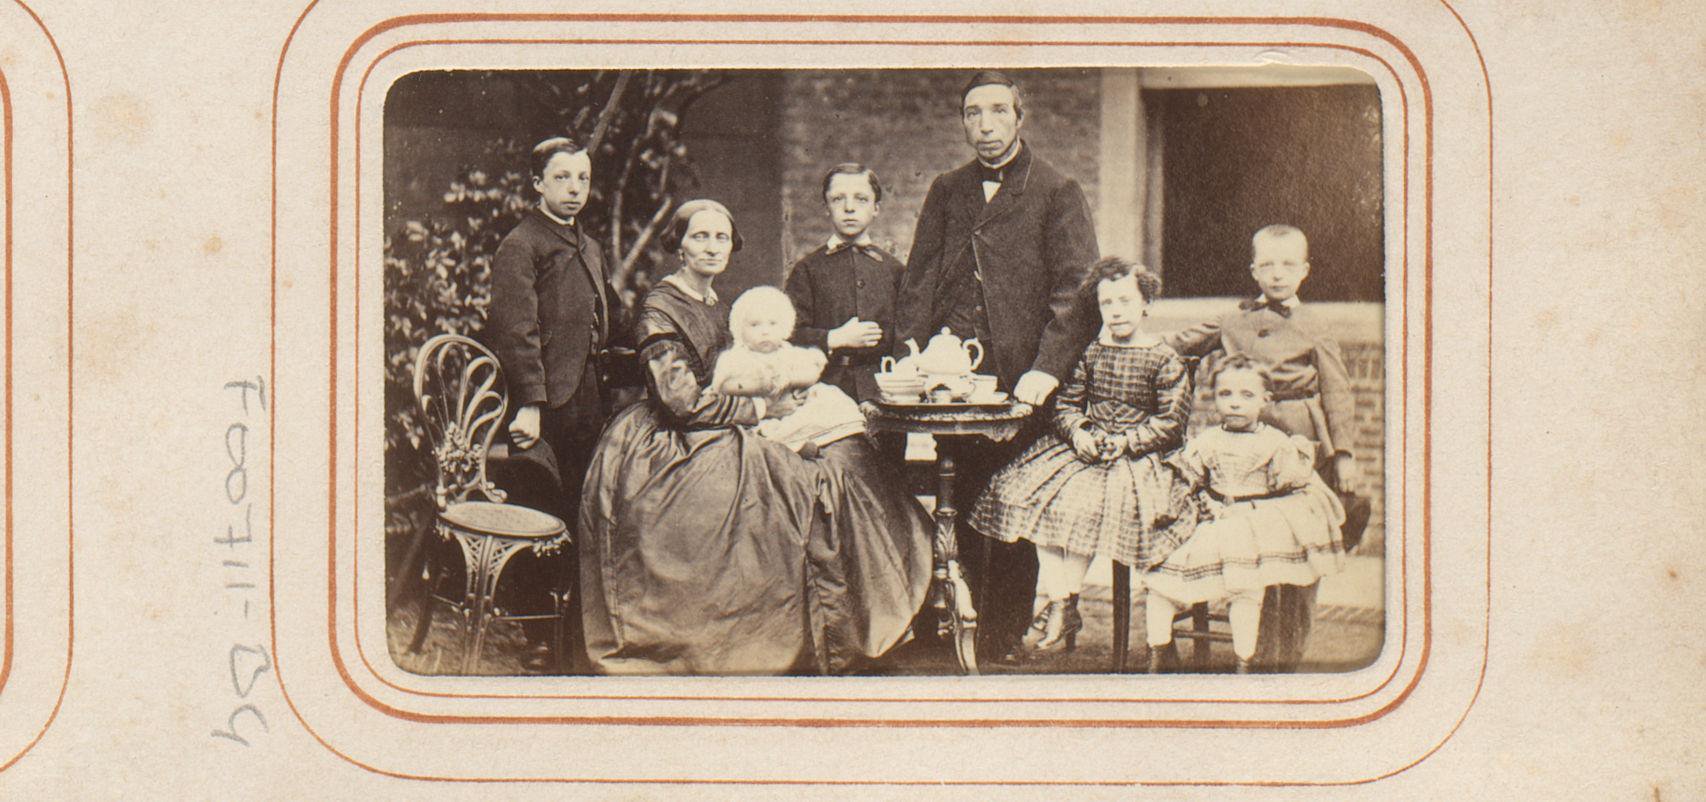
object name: carte de visite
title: Familieportret, buiten met theeservies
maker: leendert de koningh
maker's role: draughtsman, print maker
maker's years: 1777-1849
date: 1865-1887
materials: cardboard, photographic support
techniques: albumen print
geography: dordrecht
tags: tea- and coffee-service, anonymous historical persons portrayed in a group, in a group-portrait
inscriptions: inscription: ‘L de Koningh/ Dordrecht’